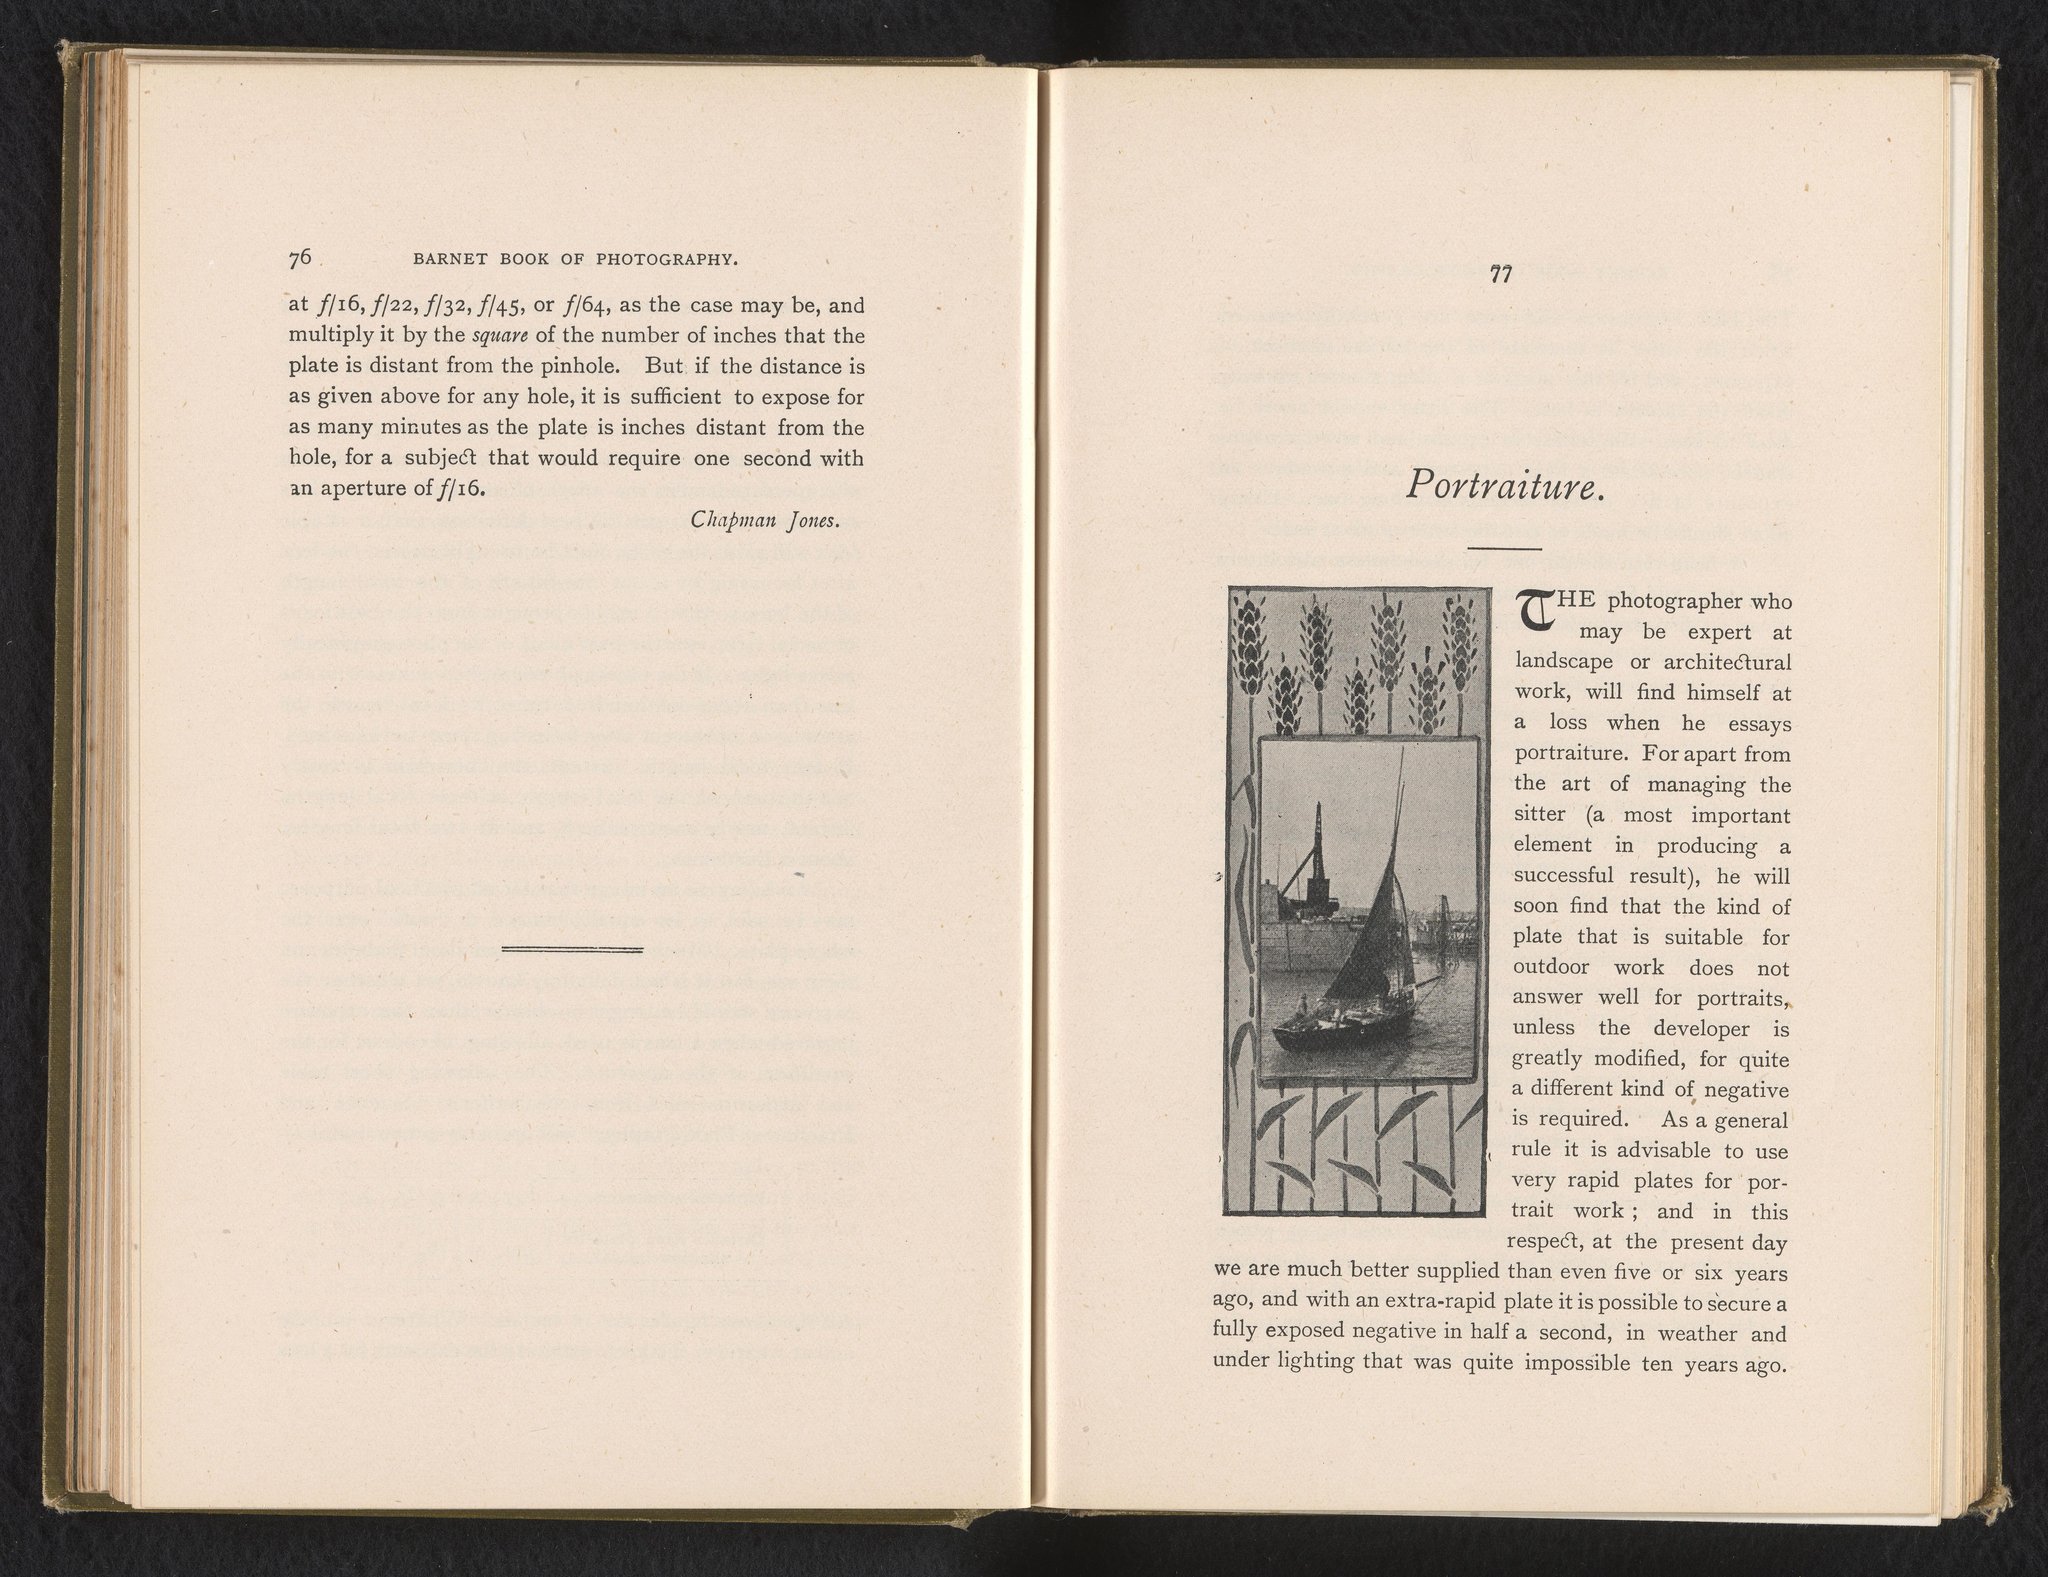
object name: photomechanical print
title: Zeilboot omlijst met graan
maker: Anonymous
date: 1895-1900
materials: paper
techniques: letterpress printing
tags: plants and herbs: wheat, sailing-ship, sailing-boat